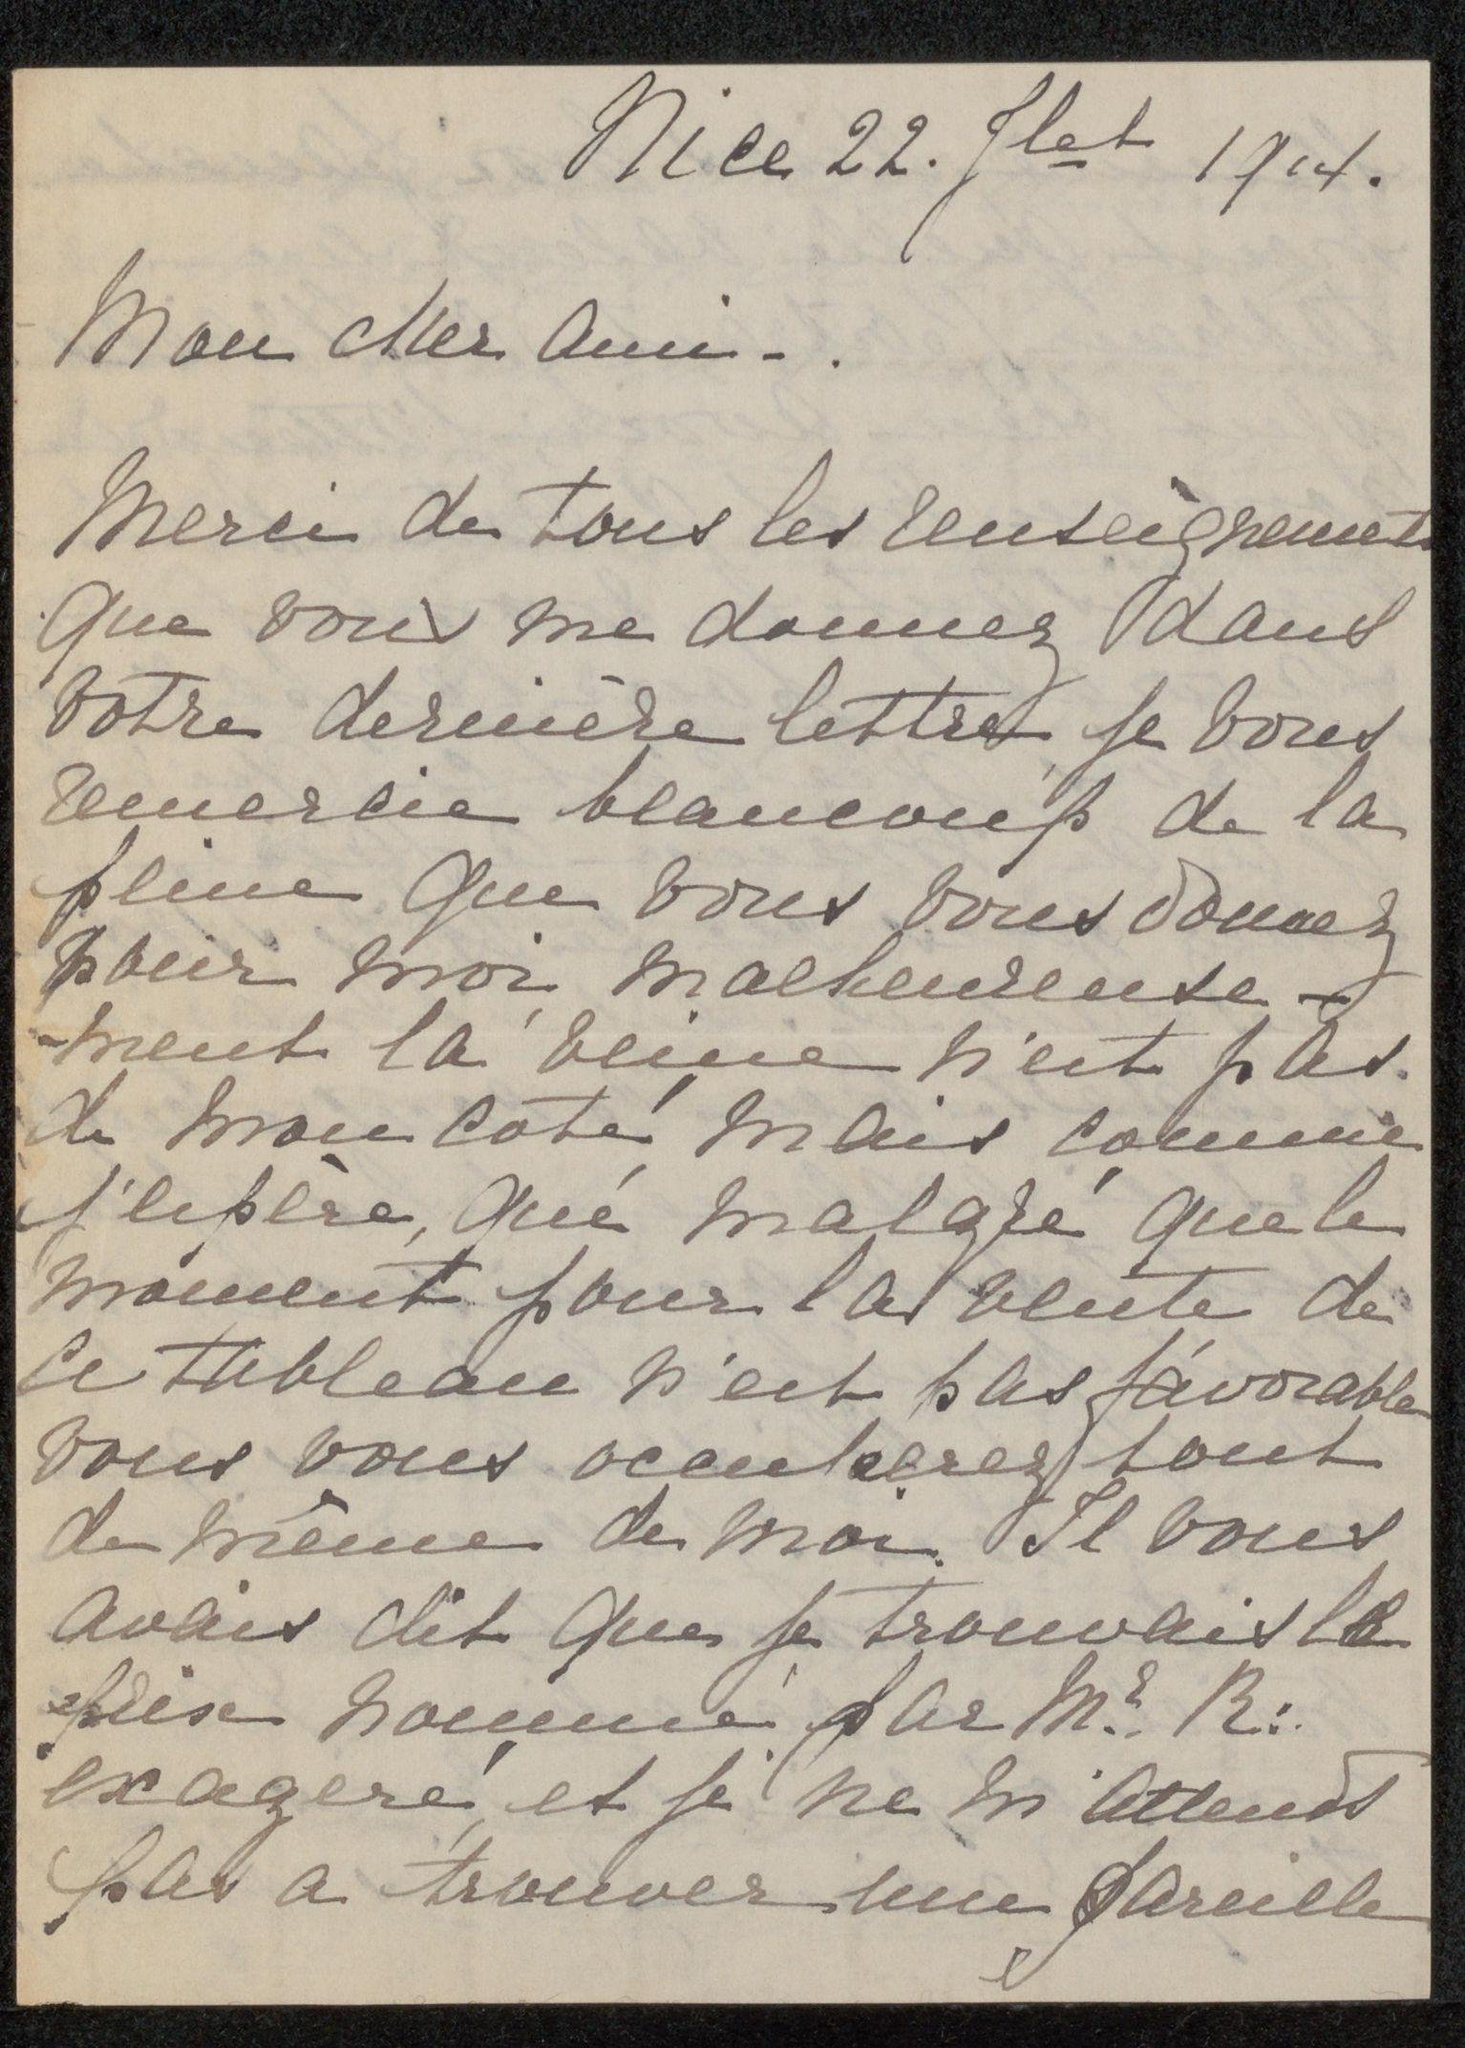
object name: letter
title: Brief aan Philip Zilcken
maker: cato l hôpital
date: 1914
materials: ink, paper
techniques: pen, writing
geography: nice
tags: amsterdam, the hague, painter, print maker, draughtsman, isaac israels, philip zilcken, painting (including book-illumination, miniature-painting)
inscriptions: address: ‘VILLA HENRIETTE/ 1, RUE CASTELLANE/ NICE’, collector's mark: ‘RPK’